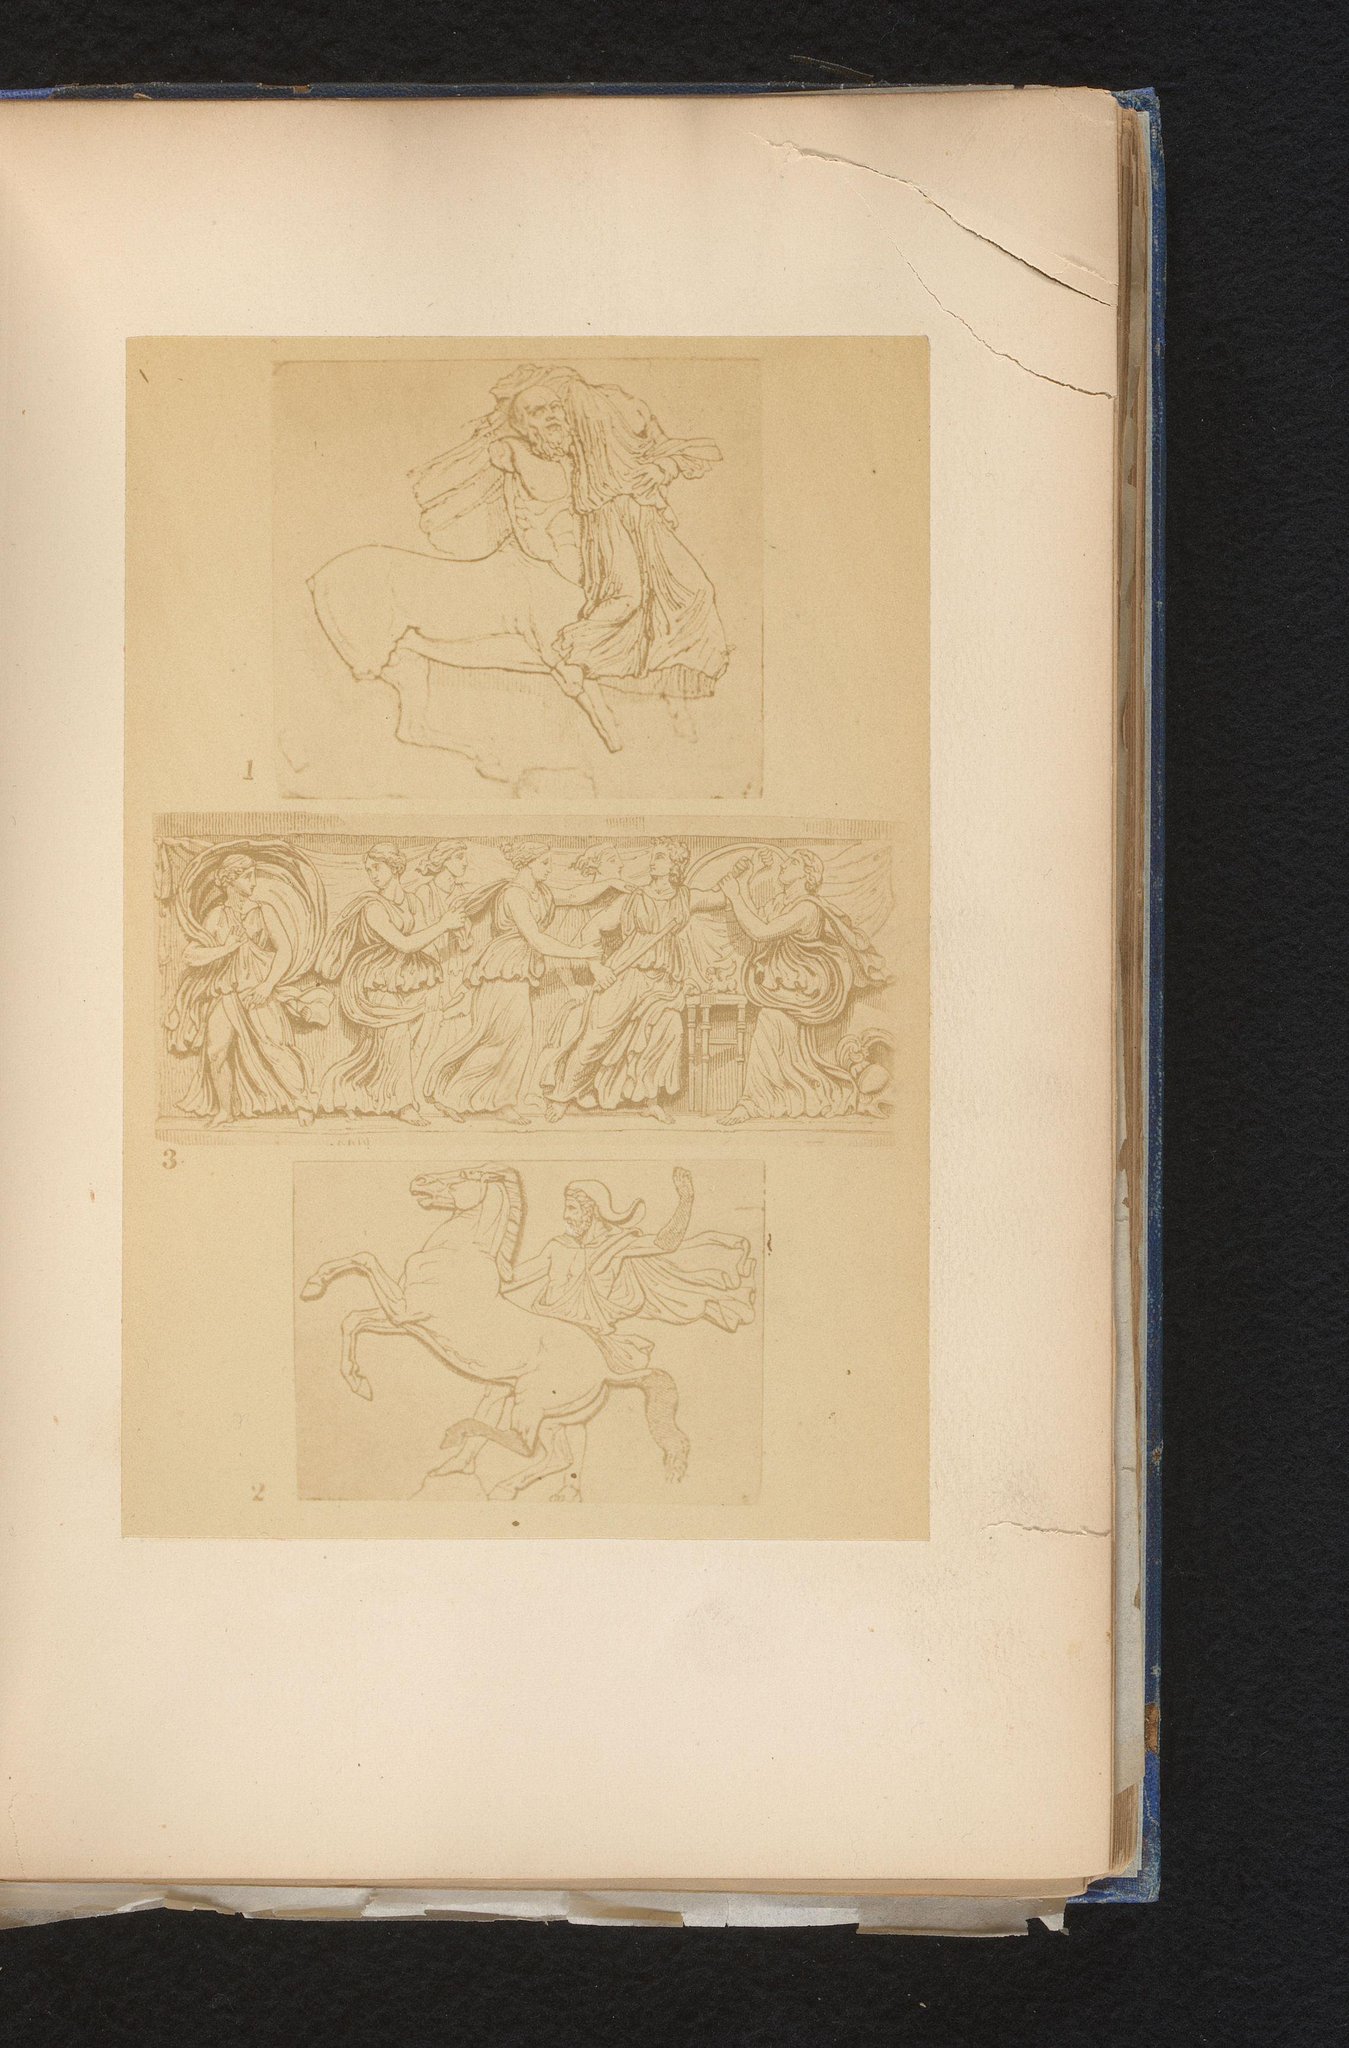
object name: page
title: Fotoreproductie van drie tekeningen van antieke reliëfs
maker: f. cole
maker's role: fotograaf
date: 1862-1867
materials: paper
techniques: albumen print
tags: centaurs, training of horses, sculpture (+ relief ~ sculpture)